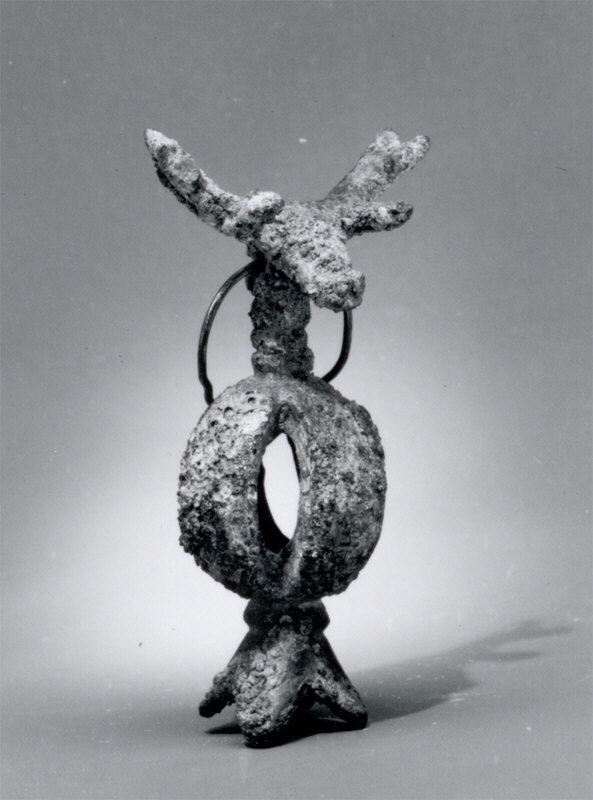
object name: rattle bell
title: Openwork rattle bell or pendant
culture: iranian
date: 1000-1 BCE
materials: bronze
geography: western iran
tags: animals